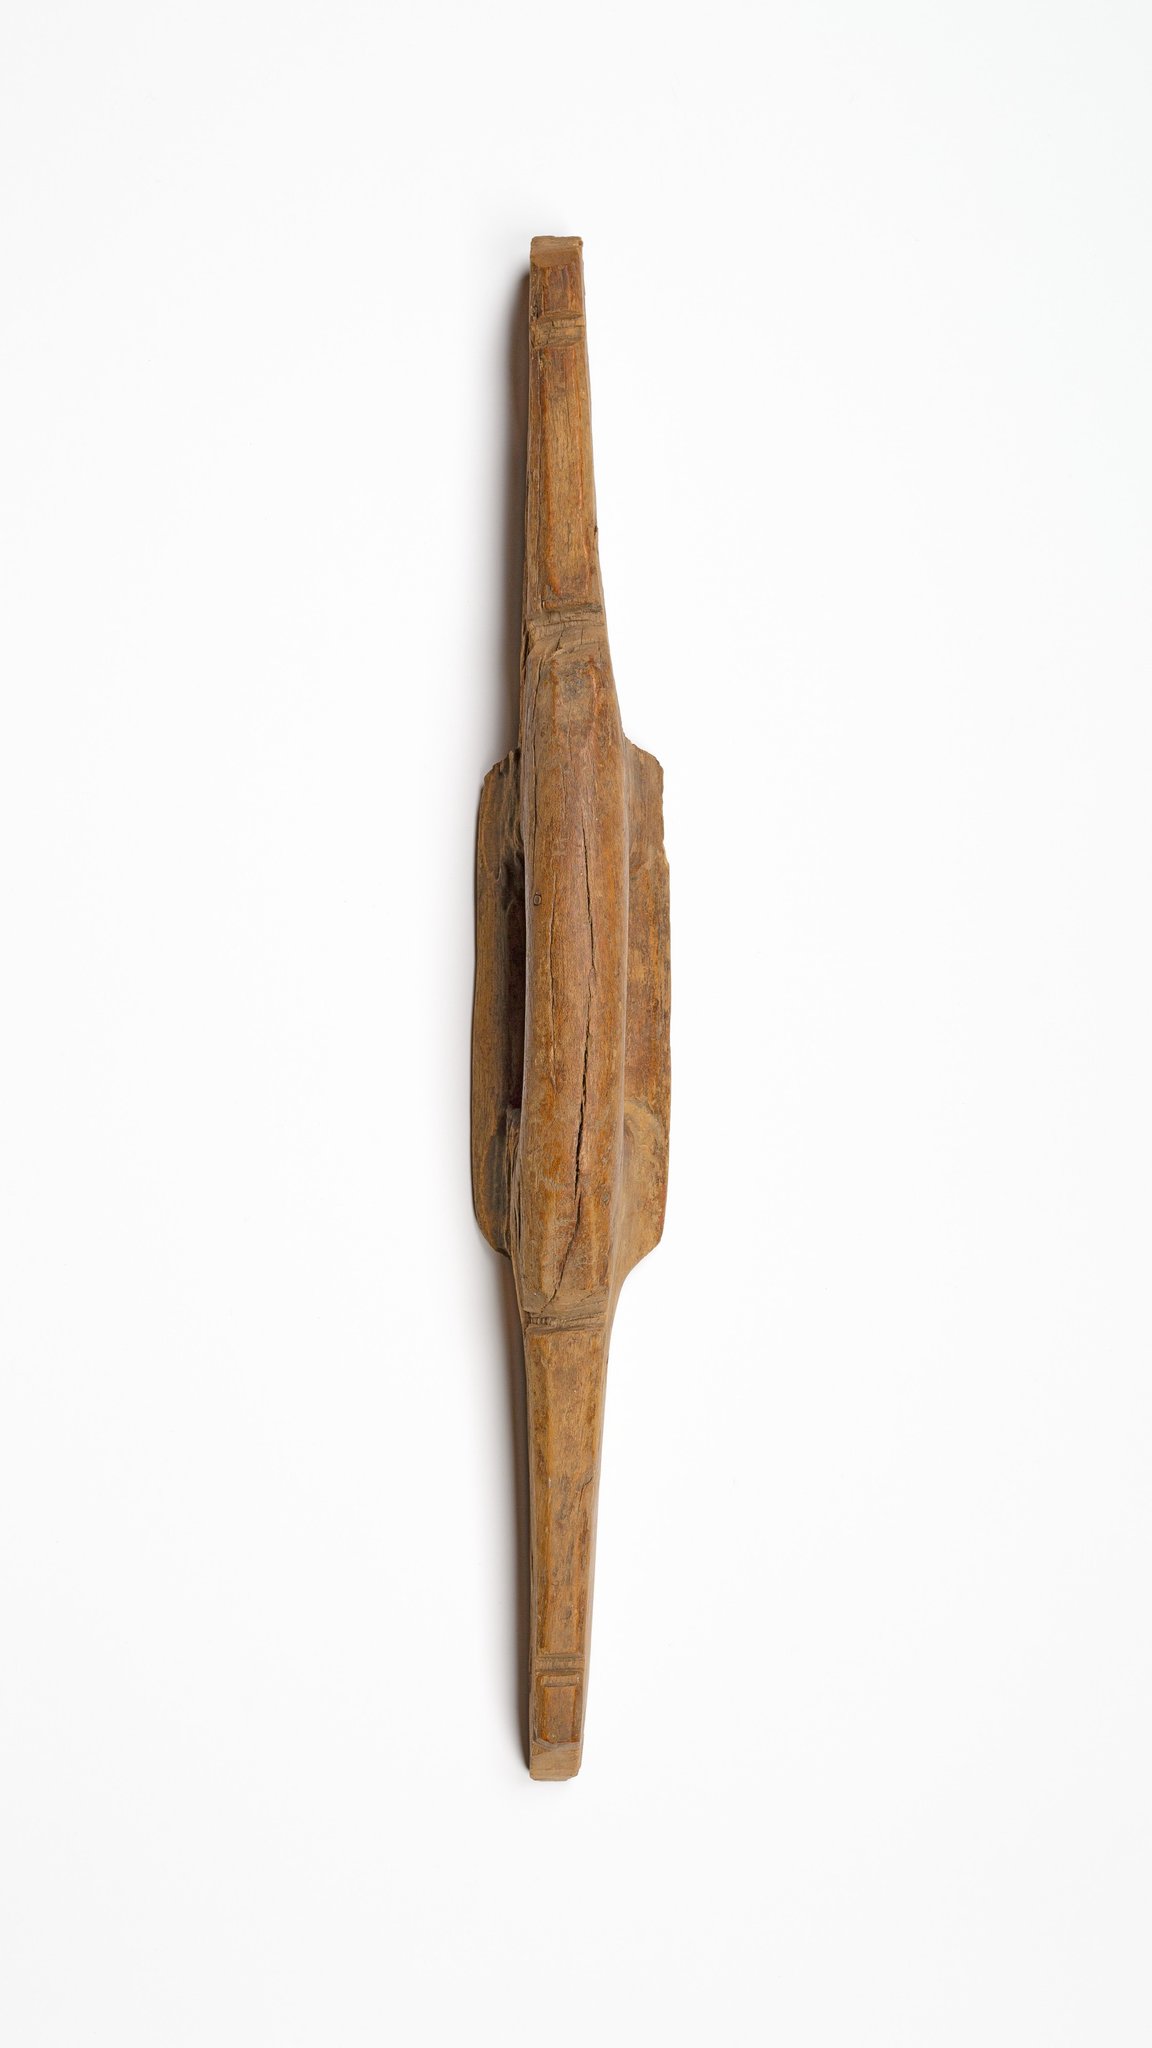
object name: shield handle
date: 2124-1504 BCE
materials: wood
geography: egypt